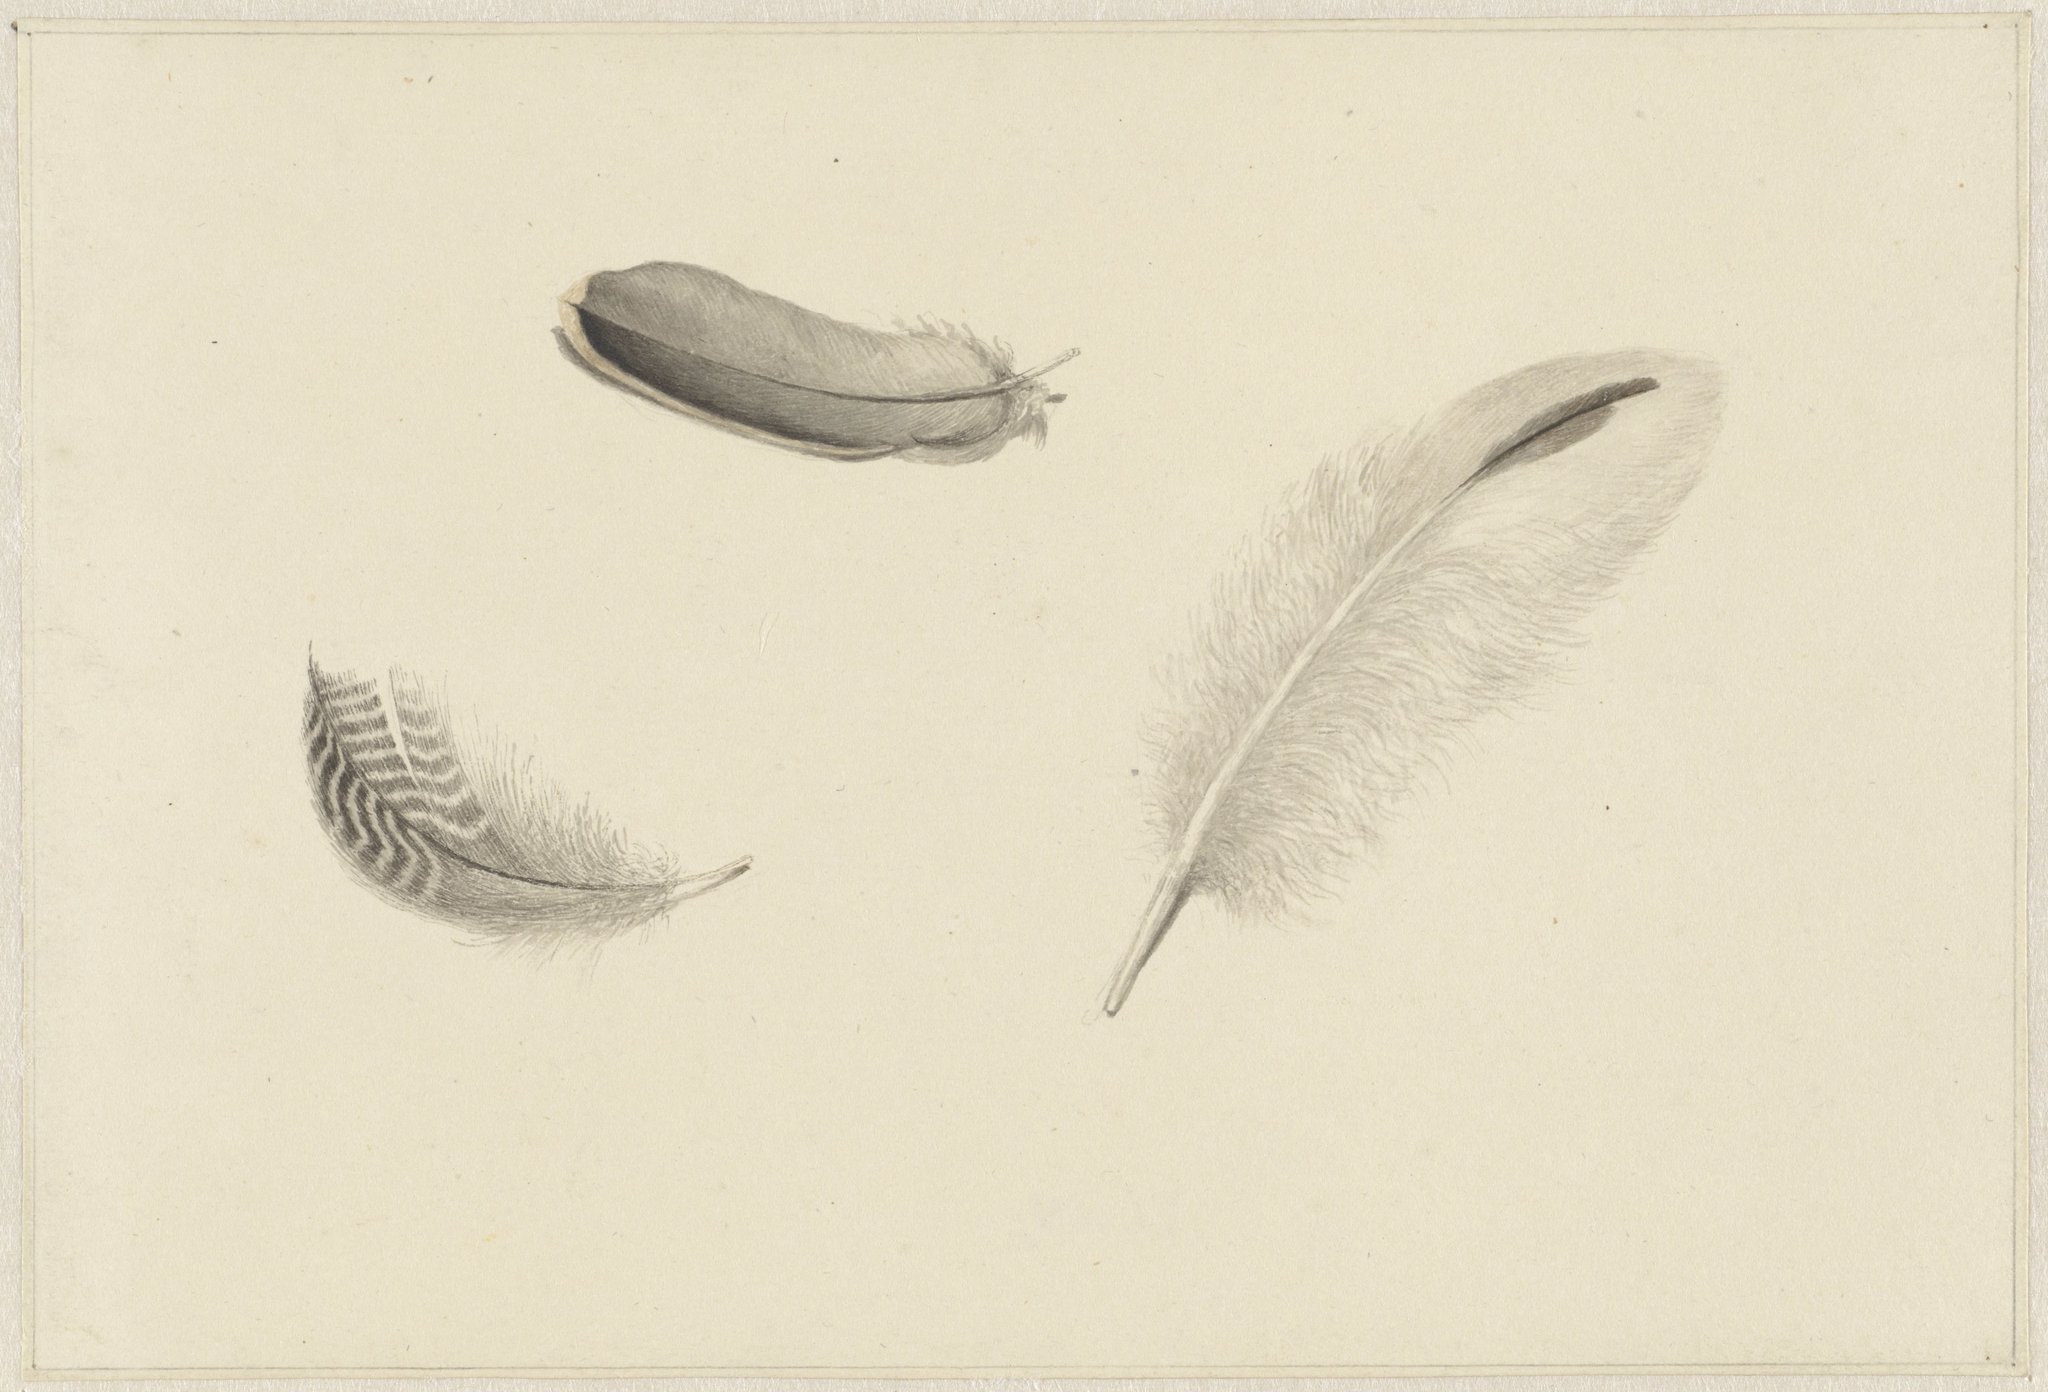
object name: drawing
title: Studie van drie veren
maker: dirk salm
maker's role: draughtsman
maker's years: 1803-1838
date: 1813-1838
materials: ink, paper, pencil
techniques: brush, pen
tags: birds (+ feathers)